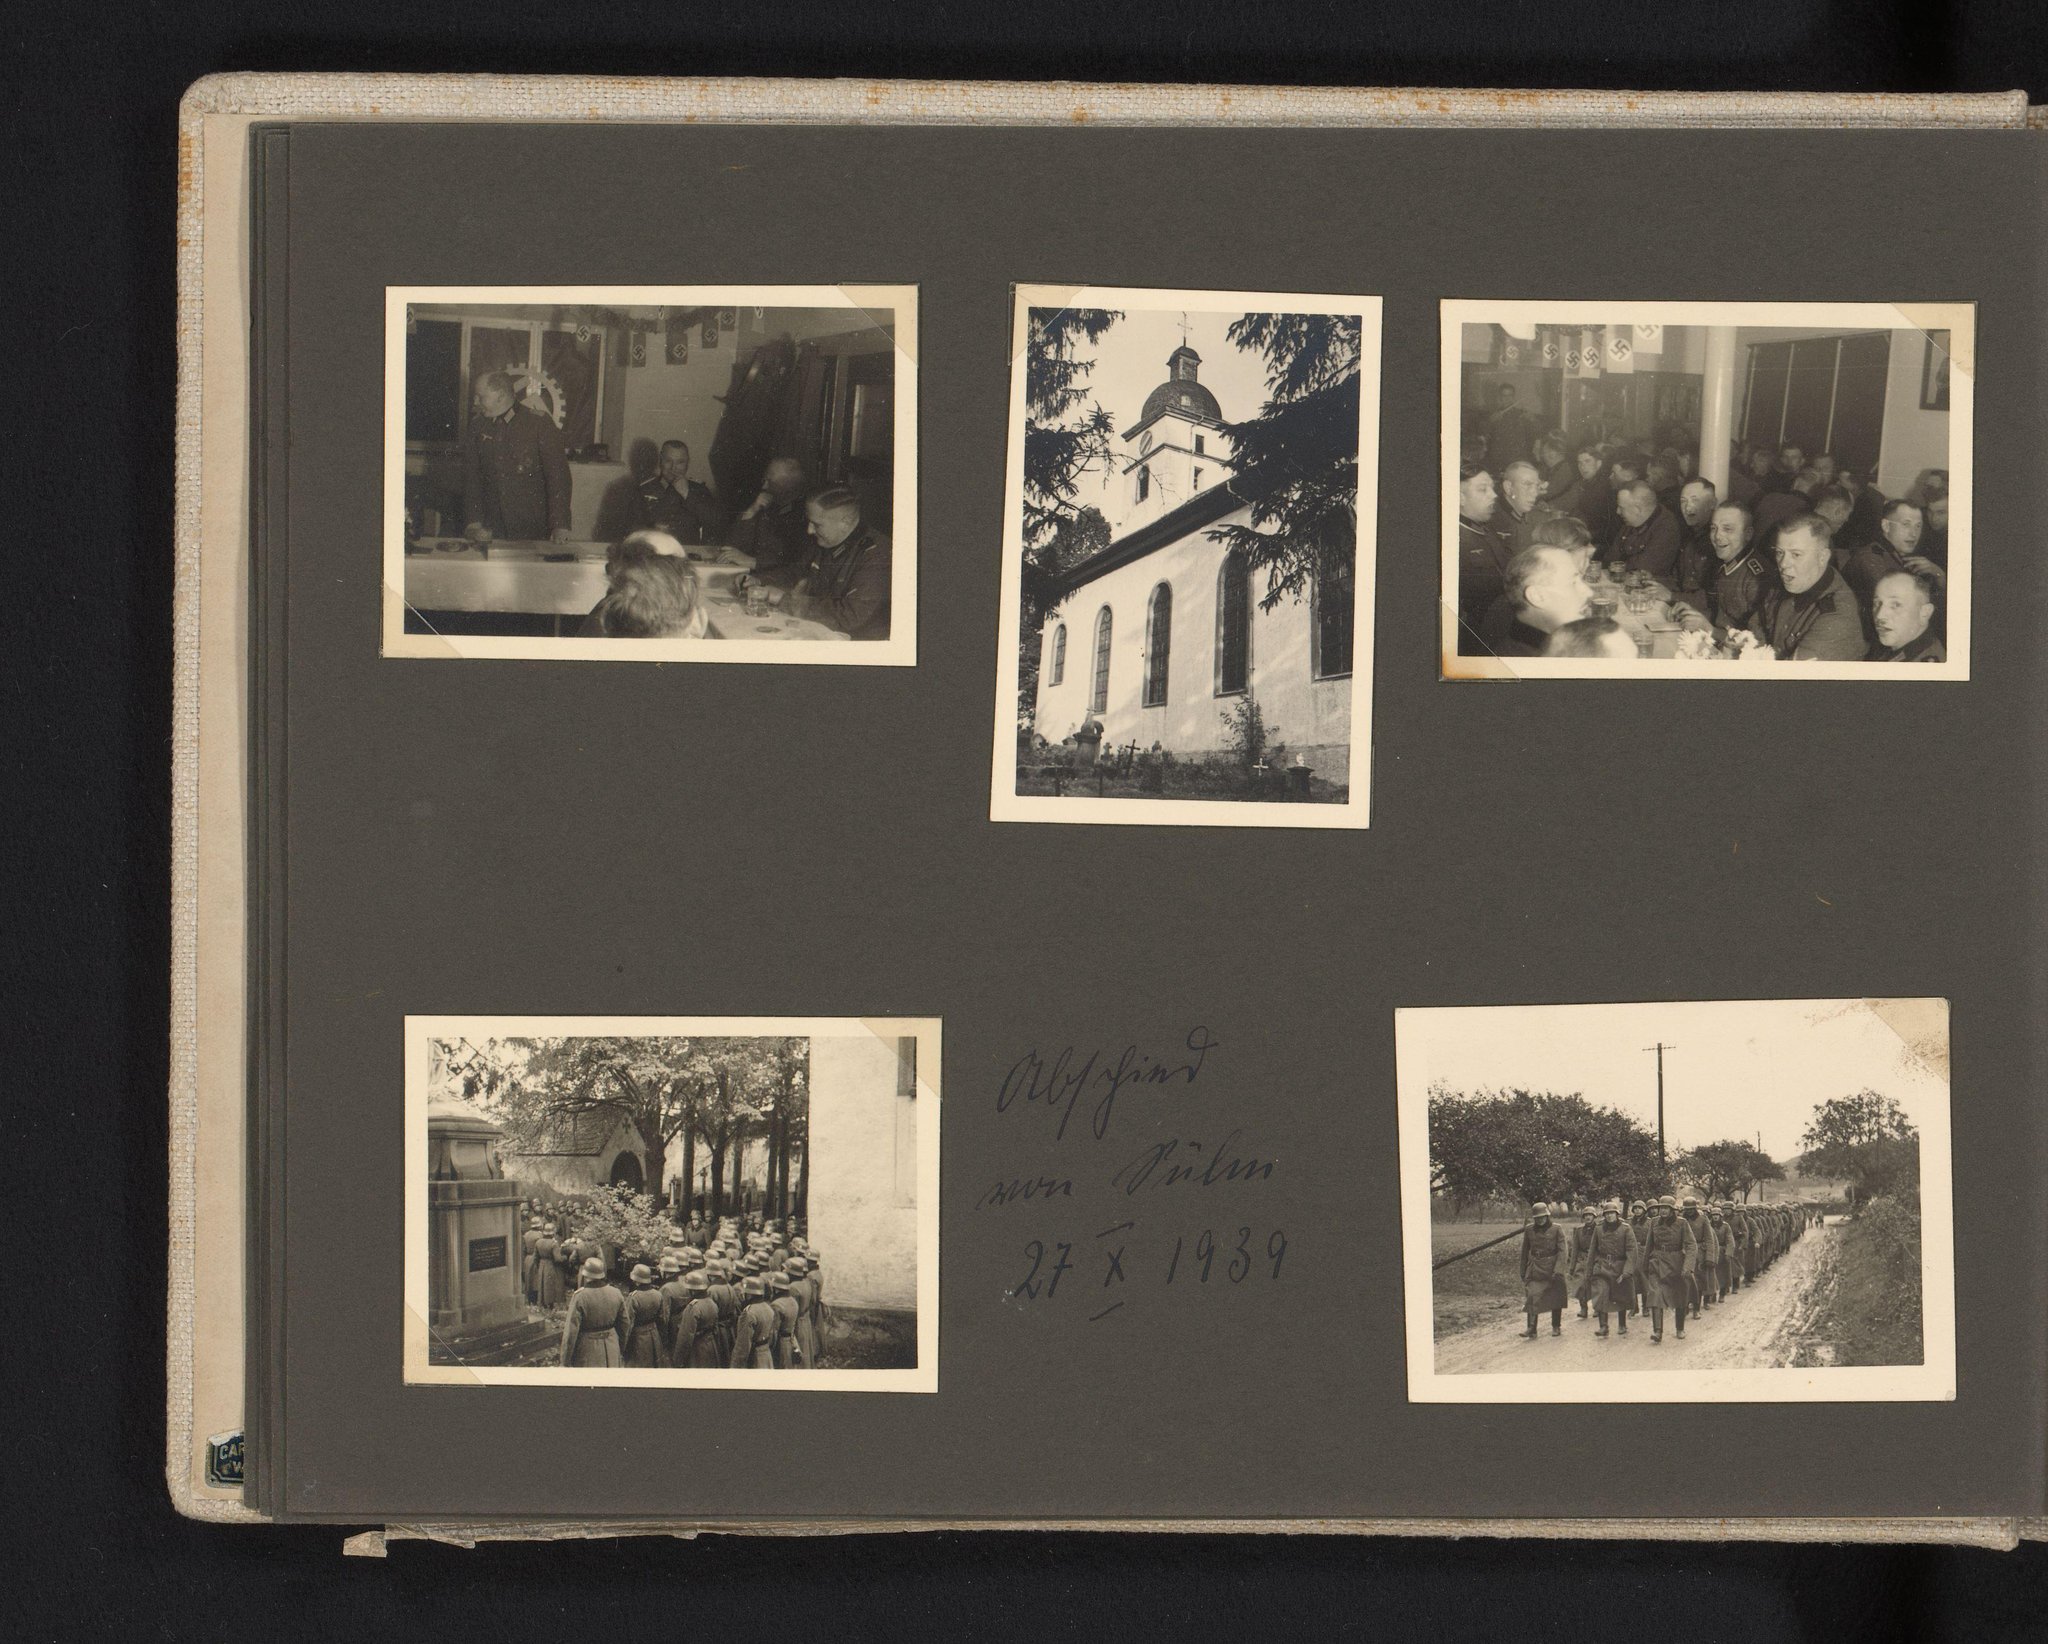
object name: album leaf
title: Feest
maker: Anonymous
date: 1910-1939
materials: cardboard, photographic support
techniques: gelatin silver print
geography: germany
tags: the company, the unit, the troop ~ military service, harvest festivities, military training, recreation ~ the soldier off duty, germany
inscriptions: inscription: ‘... von ... 27 X 1939’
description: Albumblad met vijf foto's van een feestelijke bijeenkomst van militairen (Oktoberfest?) en van de eenheid onderweg, oktober 1939. Onderdeel van de fotoalbum van de Wehrmacht 1938-1941.